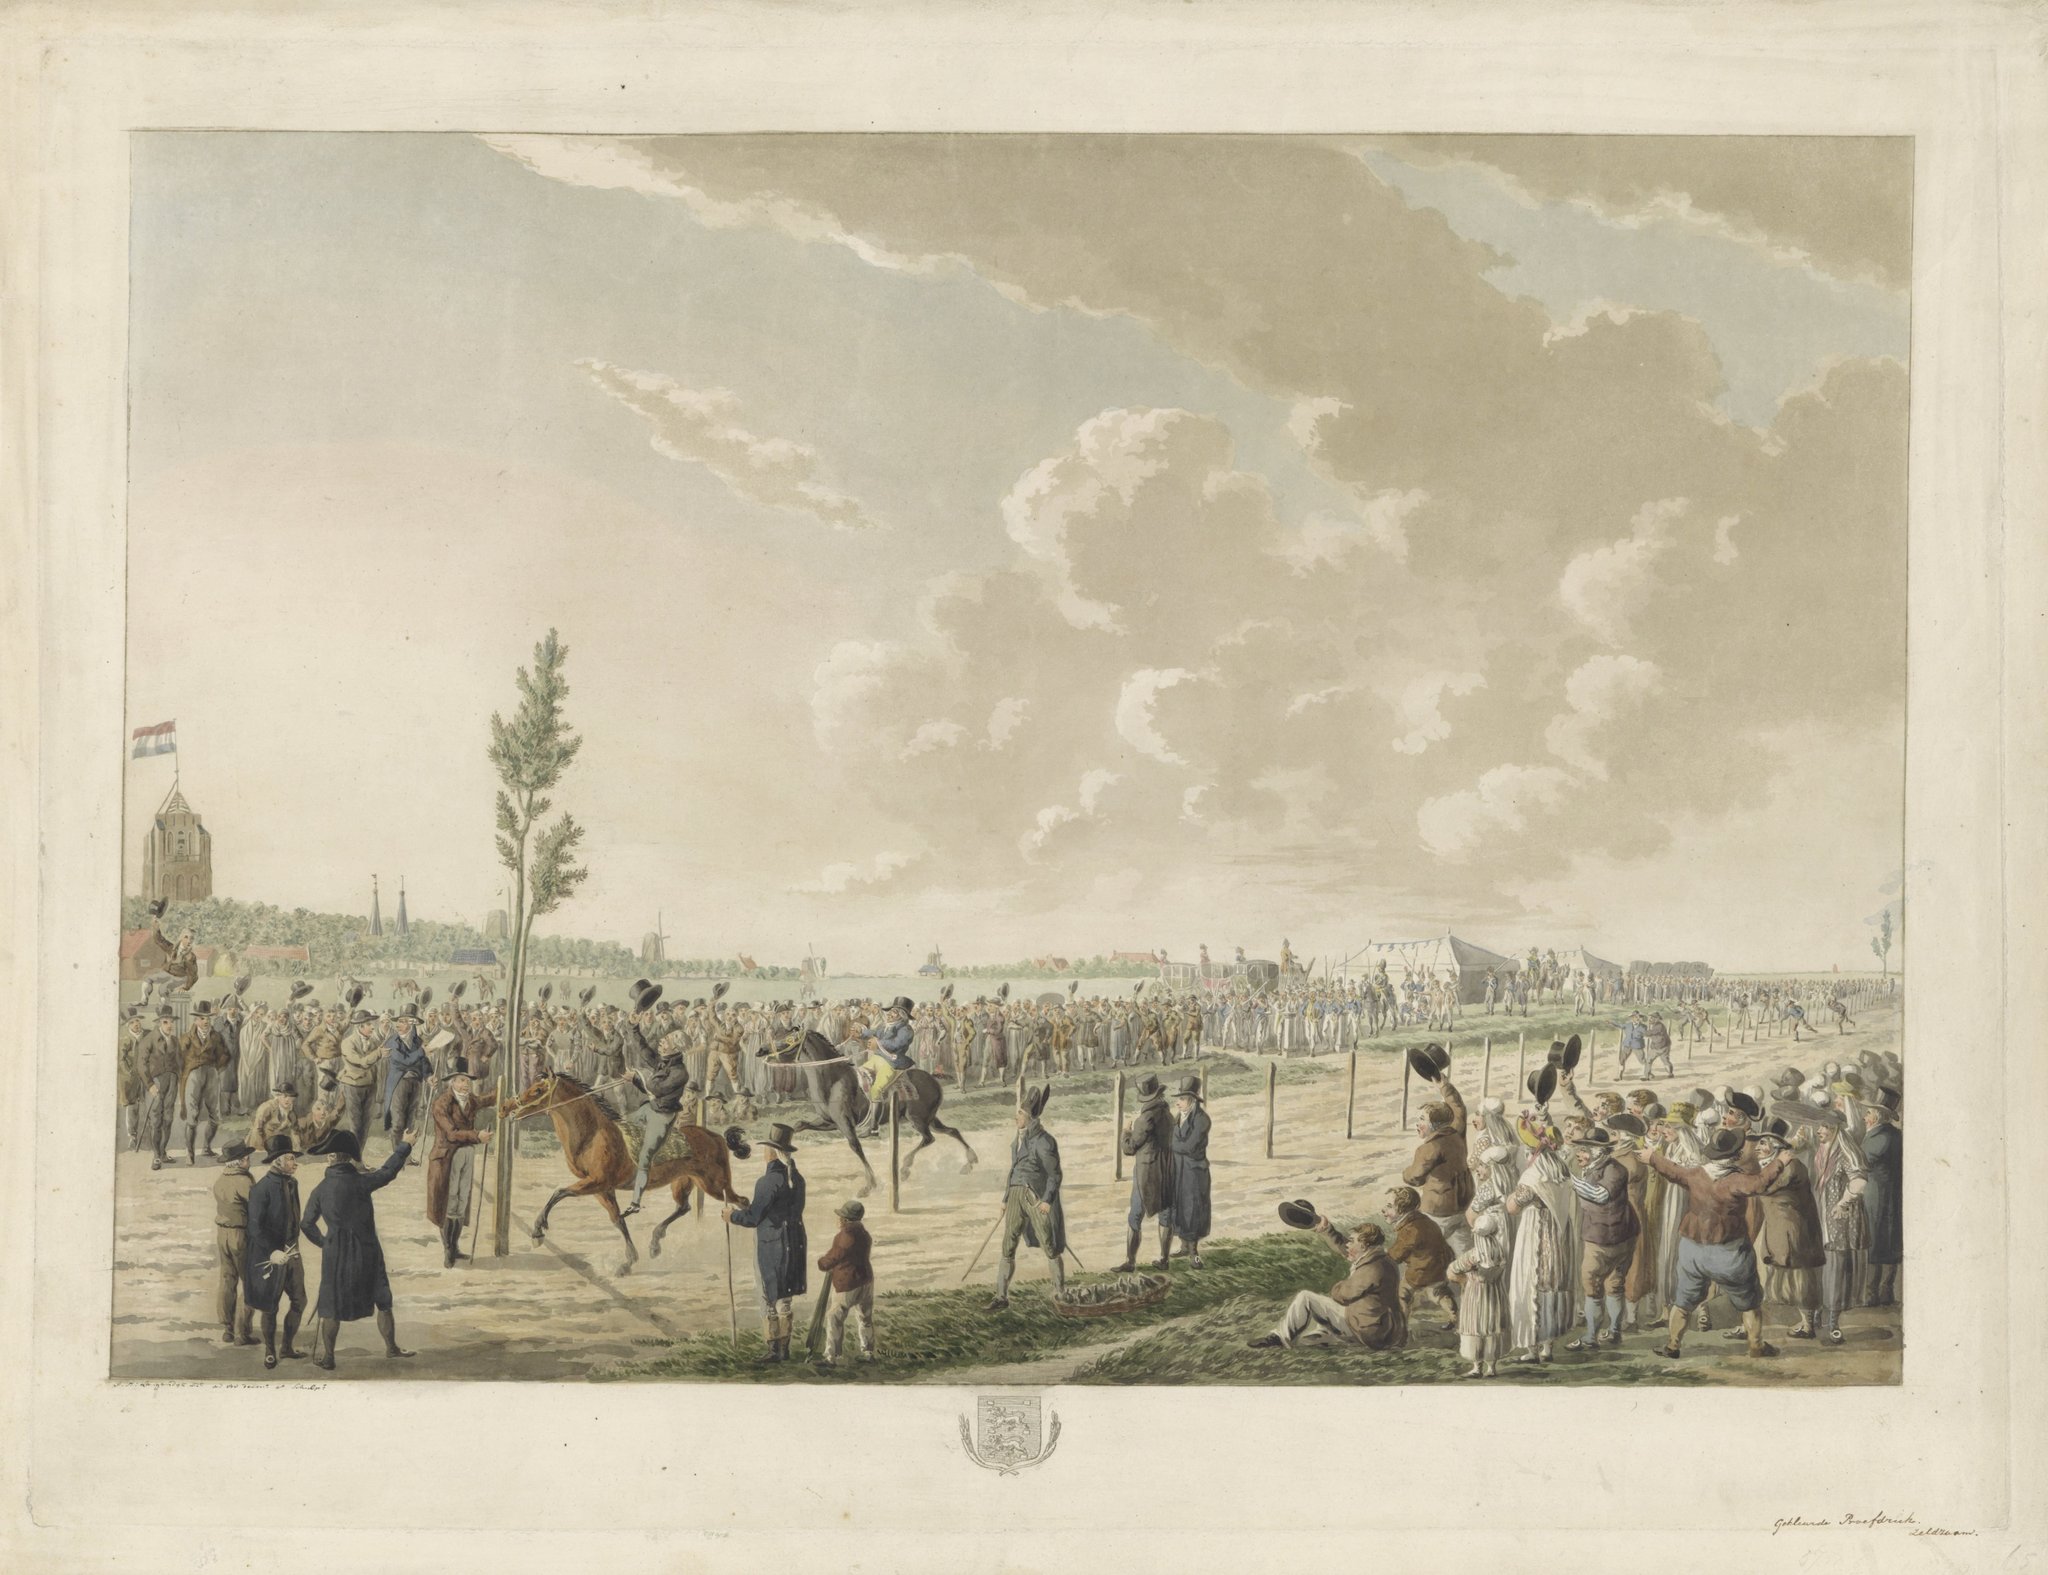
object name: print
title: Harddraverij te Leeuwarden, 1808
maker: jan anthonie langendijk dzn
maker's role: draughtsman, print maker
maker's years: 1780-1818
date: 1808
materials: paper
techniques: aquatint, brush, etching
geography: netherlands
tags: horse-racing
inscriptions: inscription: ‘Gekleurde proefdruk. Zeldzaam.’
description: Paardenraces op een vlakte buiten de stad Leeuwarden, met veel publiek aan weerszijden van de baan, 2 september 1808. In de marge het wapenschild van Friesland.